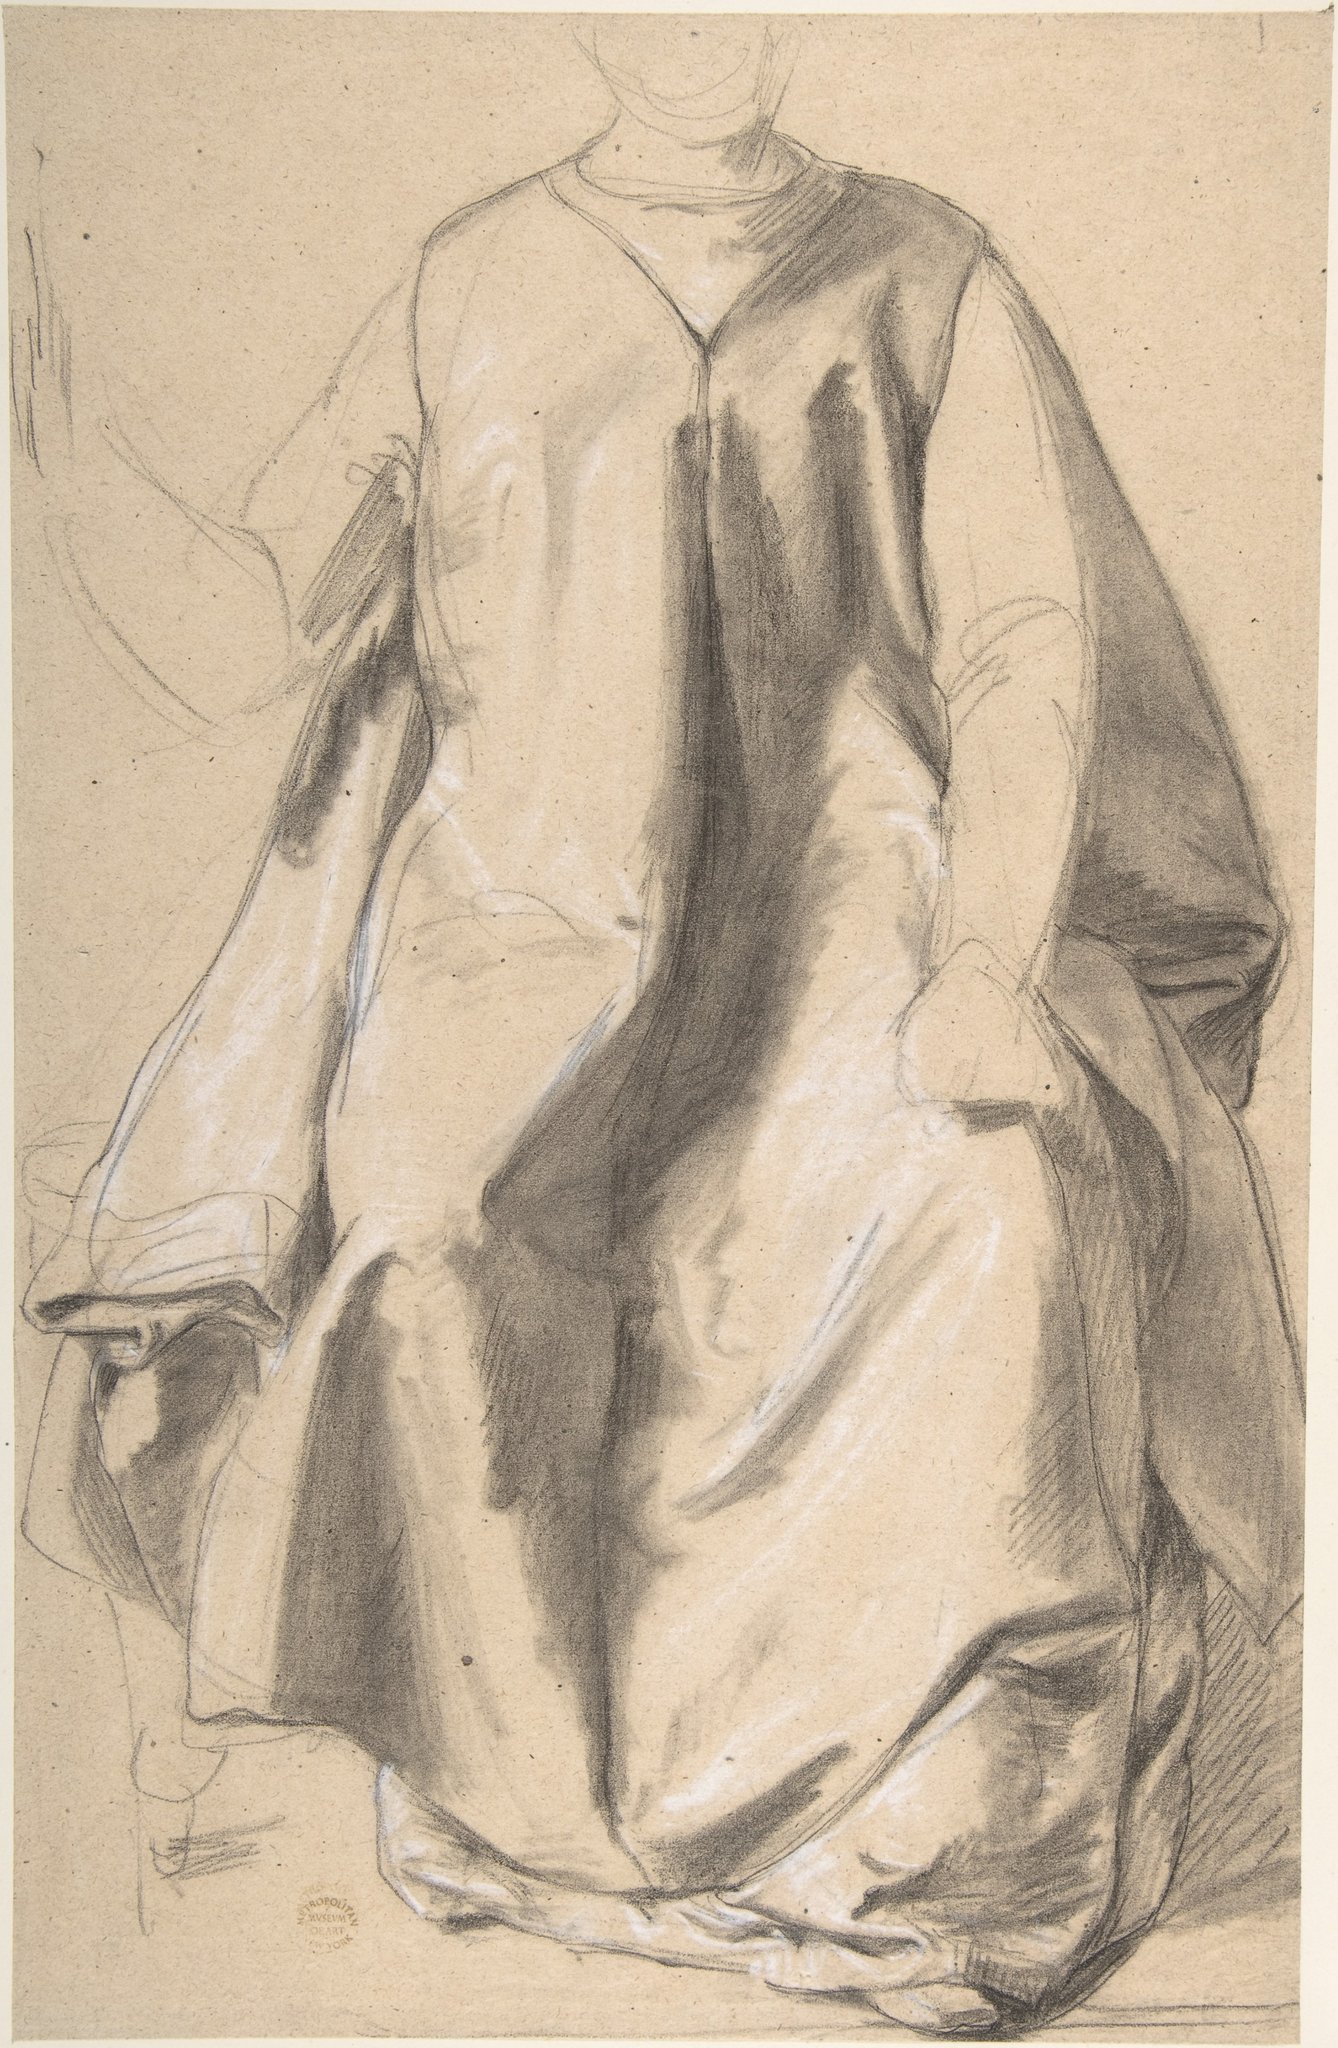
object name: drawing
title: Figure in a Long Robe, Seated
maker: romain cazes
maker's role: artist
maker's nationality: french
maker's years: 1808-1881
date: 1828-1881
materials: chalk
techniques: highlighting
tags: robes